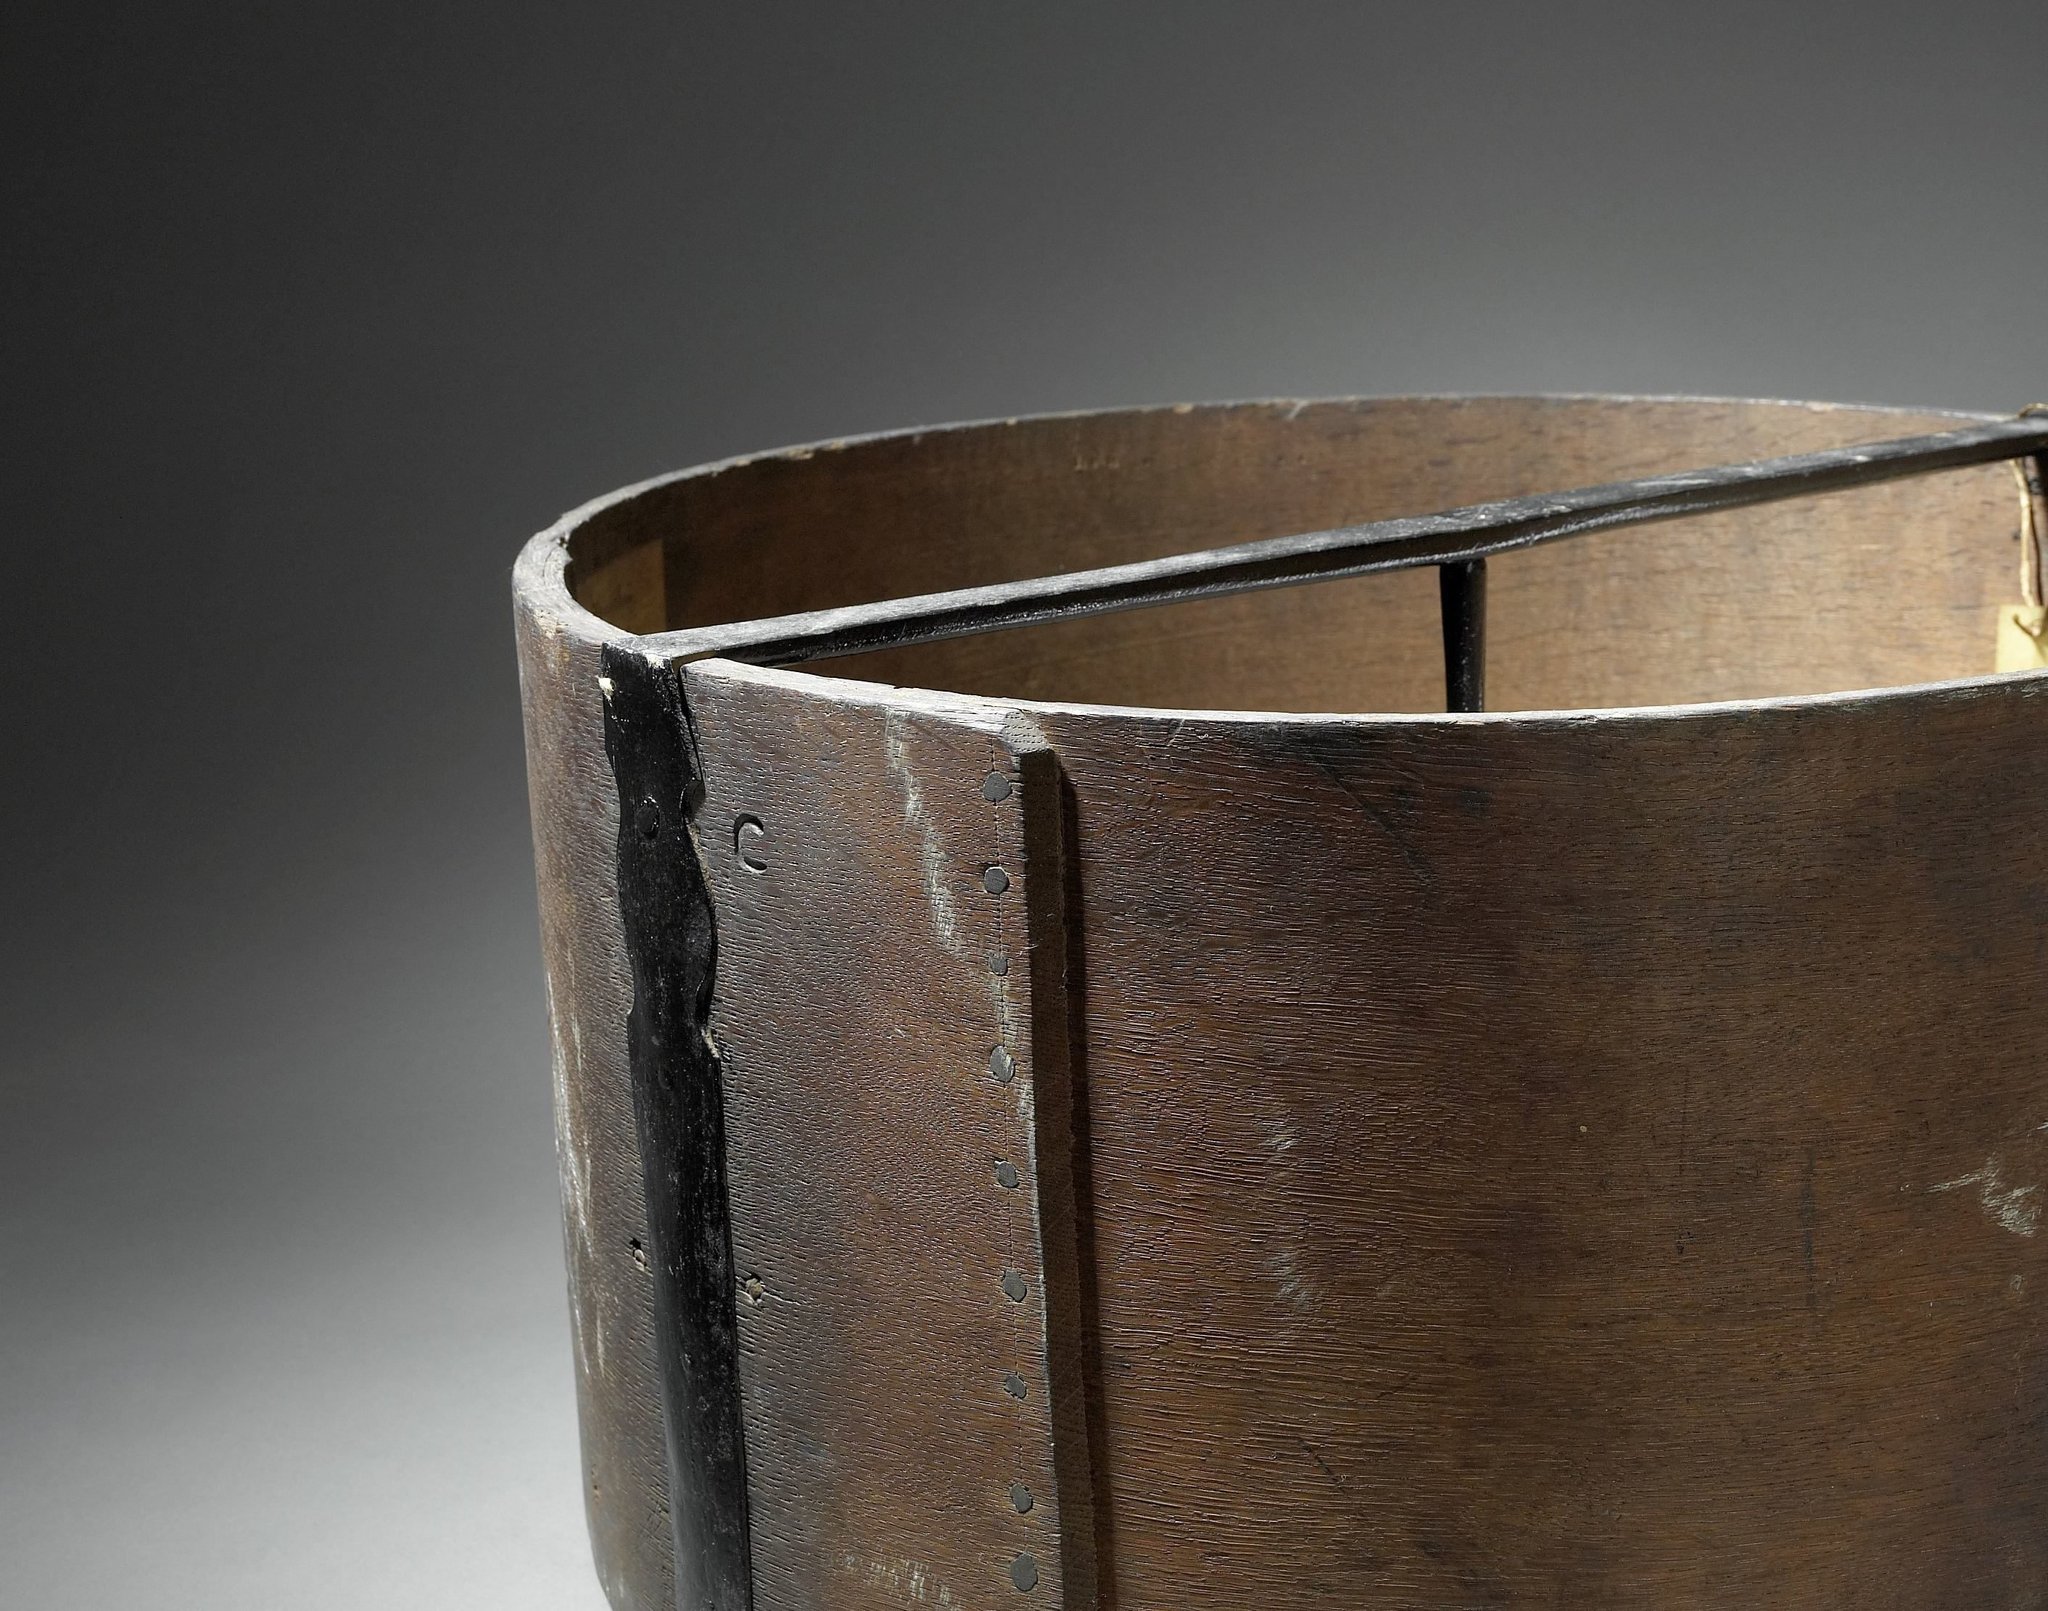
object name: inhoudsmaat droge waren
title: 1 Aggele uit Haarlem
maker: Anonymous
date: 1800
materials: iron, wood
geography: haarlem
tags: haarlem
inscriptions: title: ‘d'Haarlem un Boisseau’, title: ‘Haarlem een Aggele’, : ‘56’, mark: ‘C’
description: Spanen en ijzeren inhoudsmaat voor droge waren met brug en stijl van 1 aggele, v.z.v. merk en etiketten.